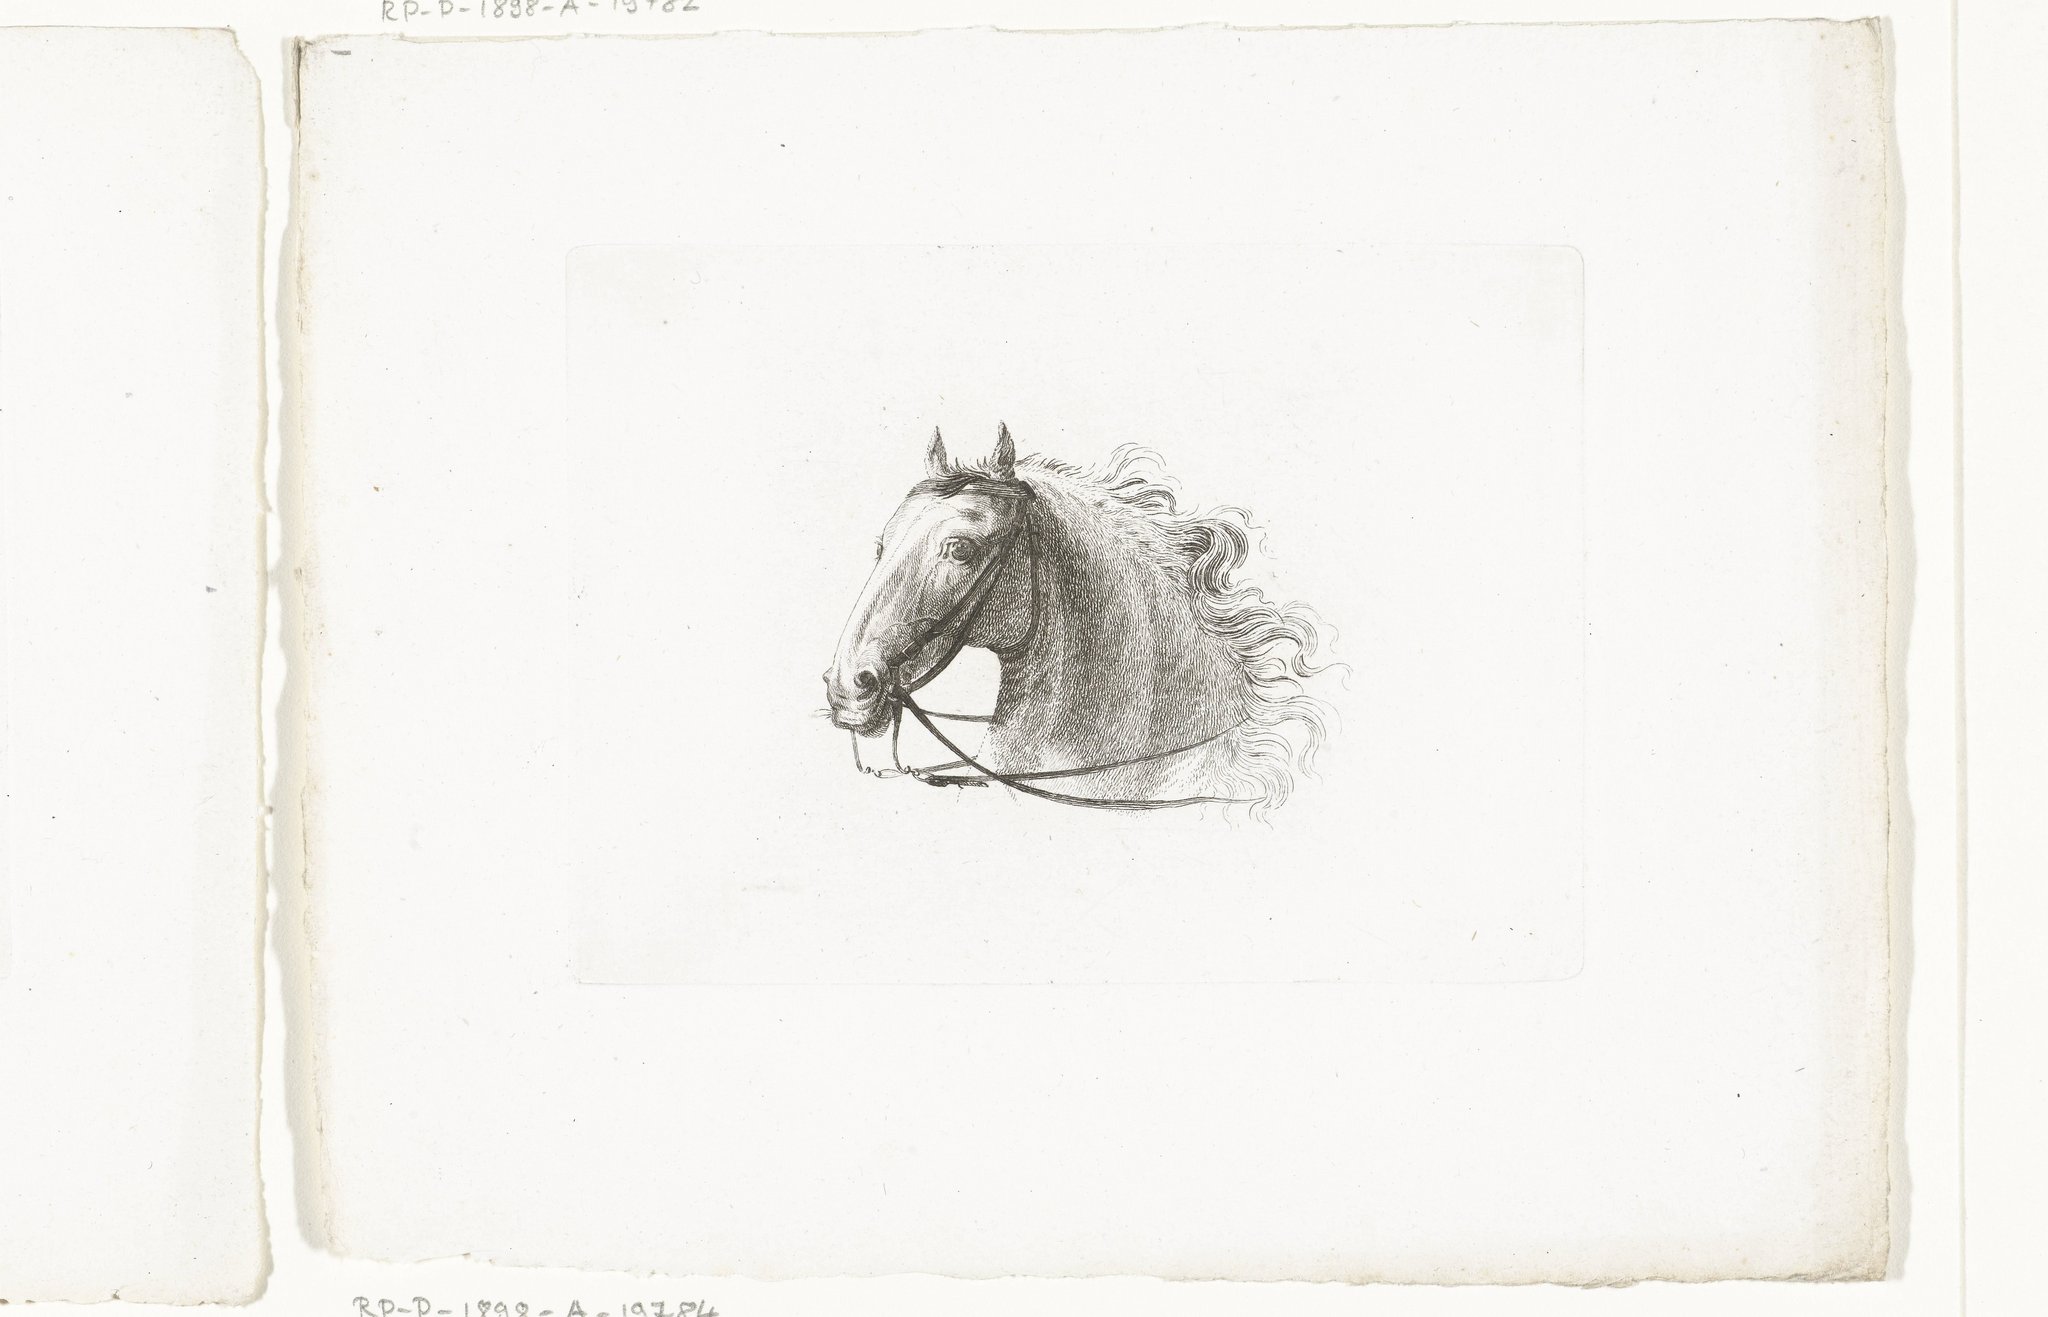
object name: print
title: Paardenhoofden naar Gerrit Malleyn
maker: joannes bemme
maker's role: print maker, printer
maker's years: 1775-1841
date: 1801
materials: paper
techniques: etching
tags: horse (+ head of an animal)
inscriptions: collector's mark: Lugt 2228